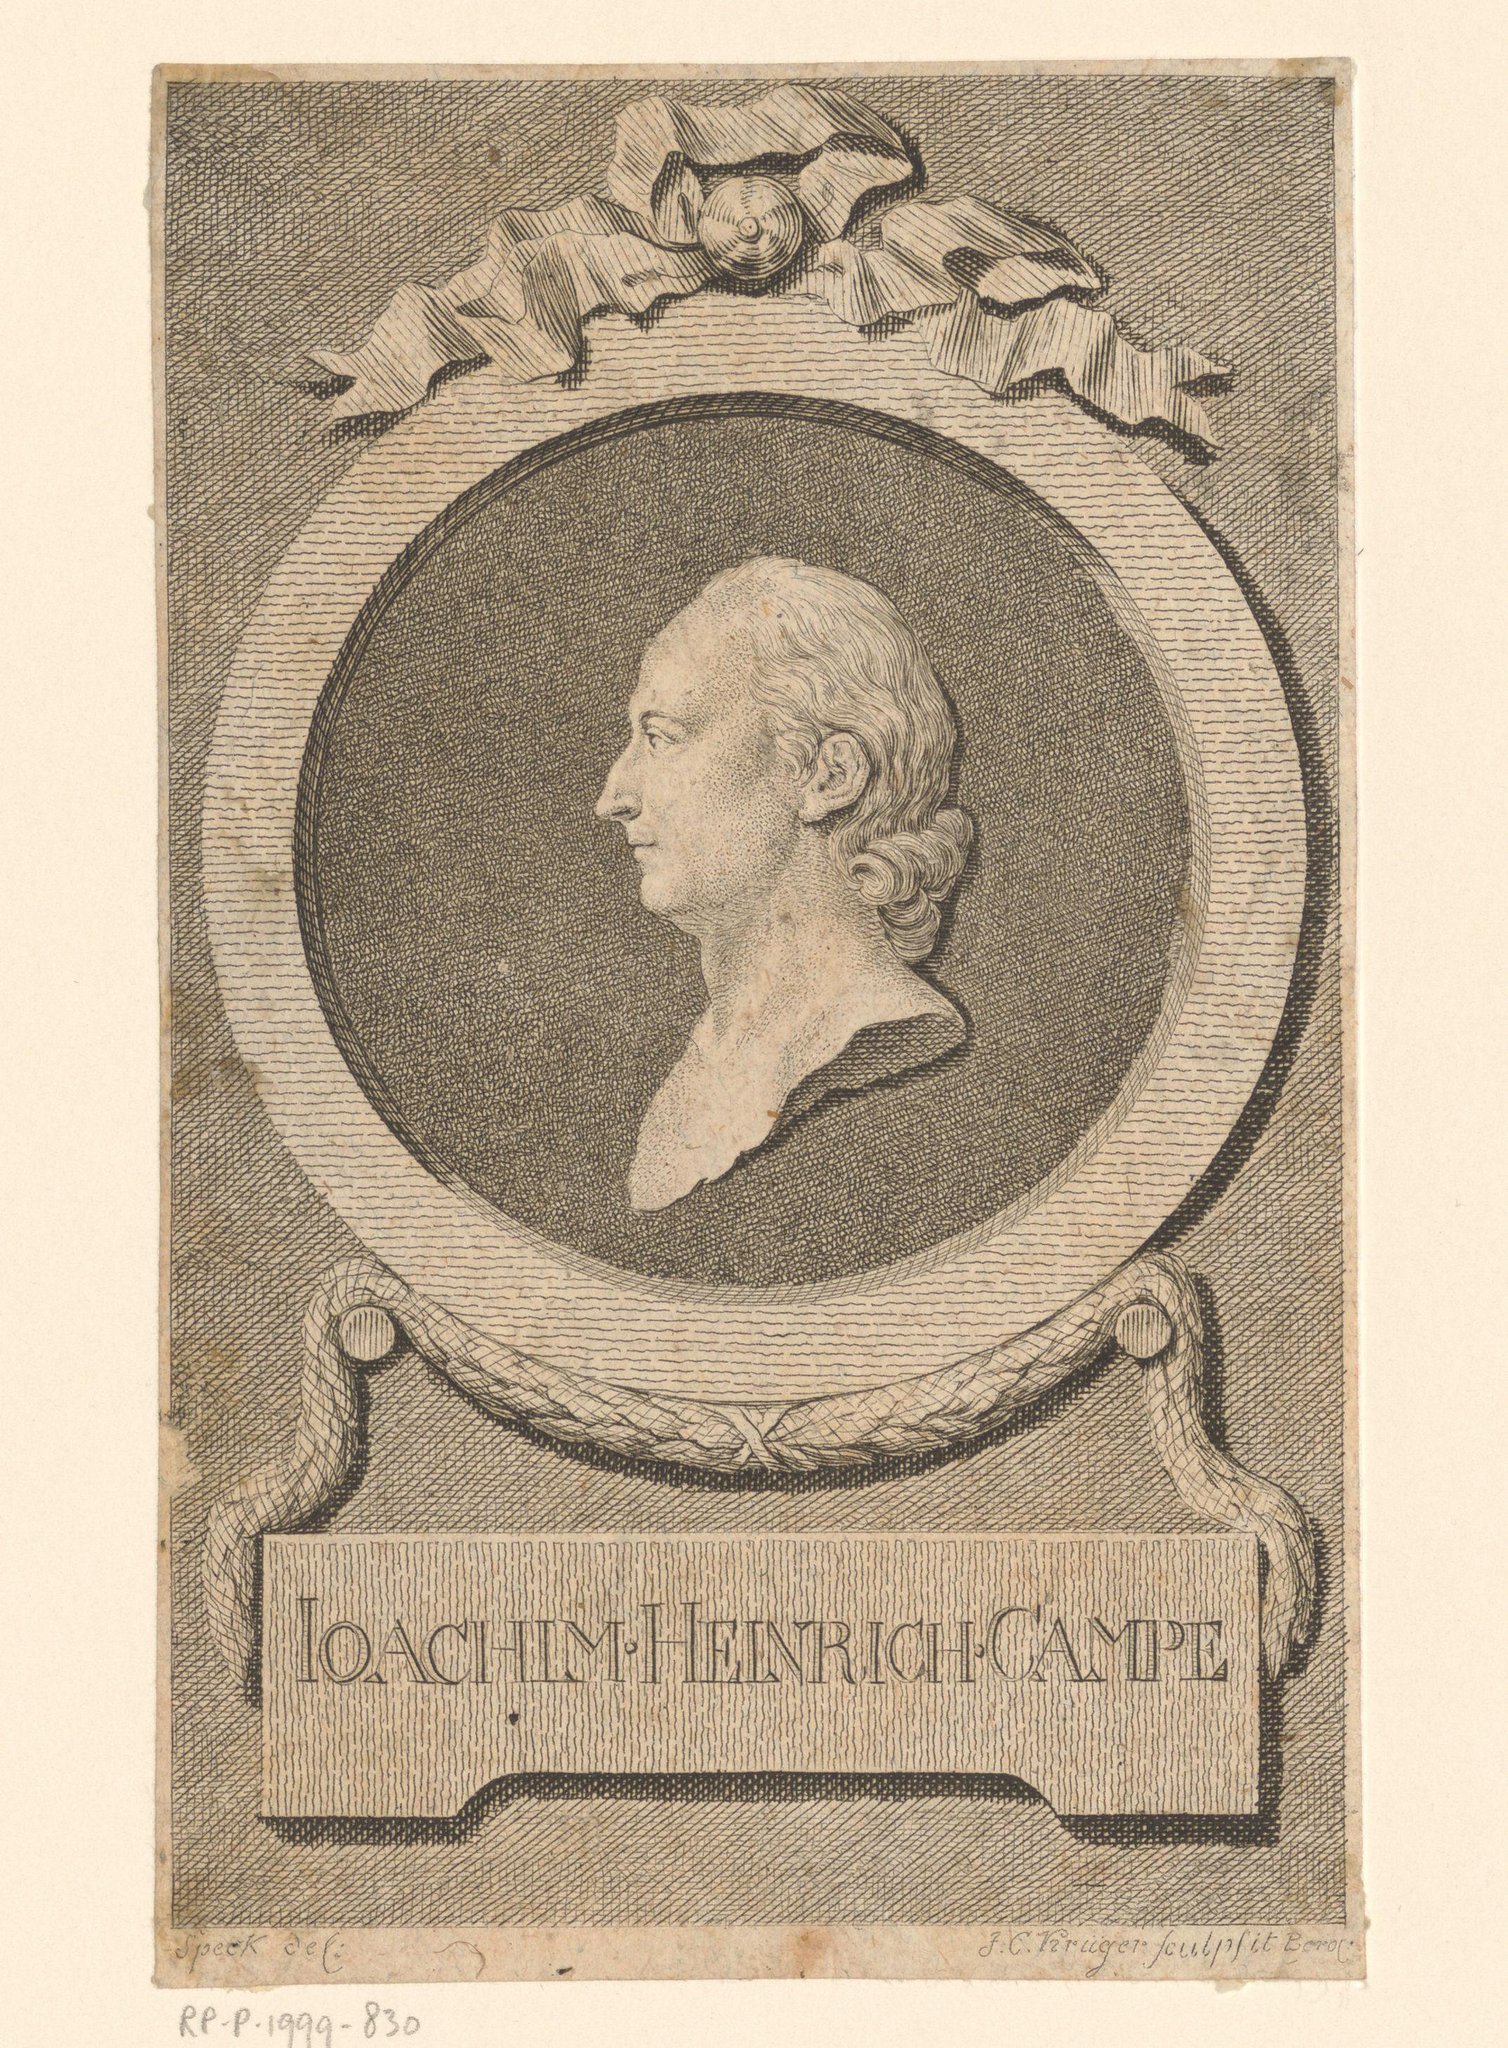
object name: print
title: Portret van Joachim Heinrich Campe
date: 1766-1791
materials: paper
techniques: etching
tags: joachim heinrich campe, historical persons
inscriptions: collector's mark: Lugt 2760, collector's mark: Lugt 2228